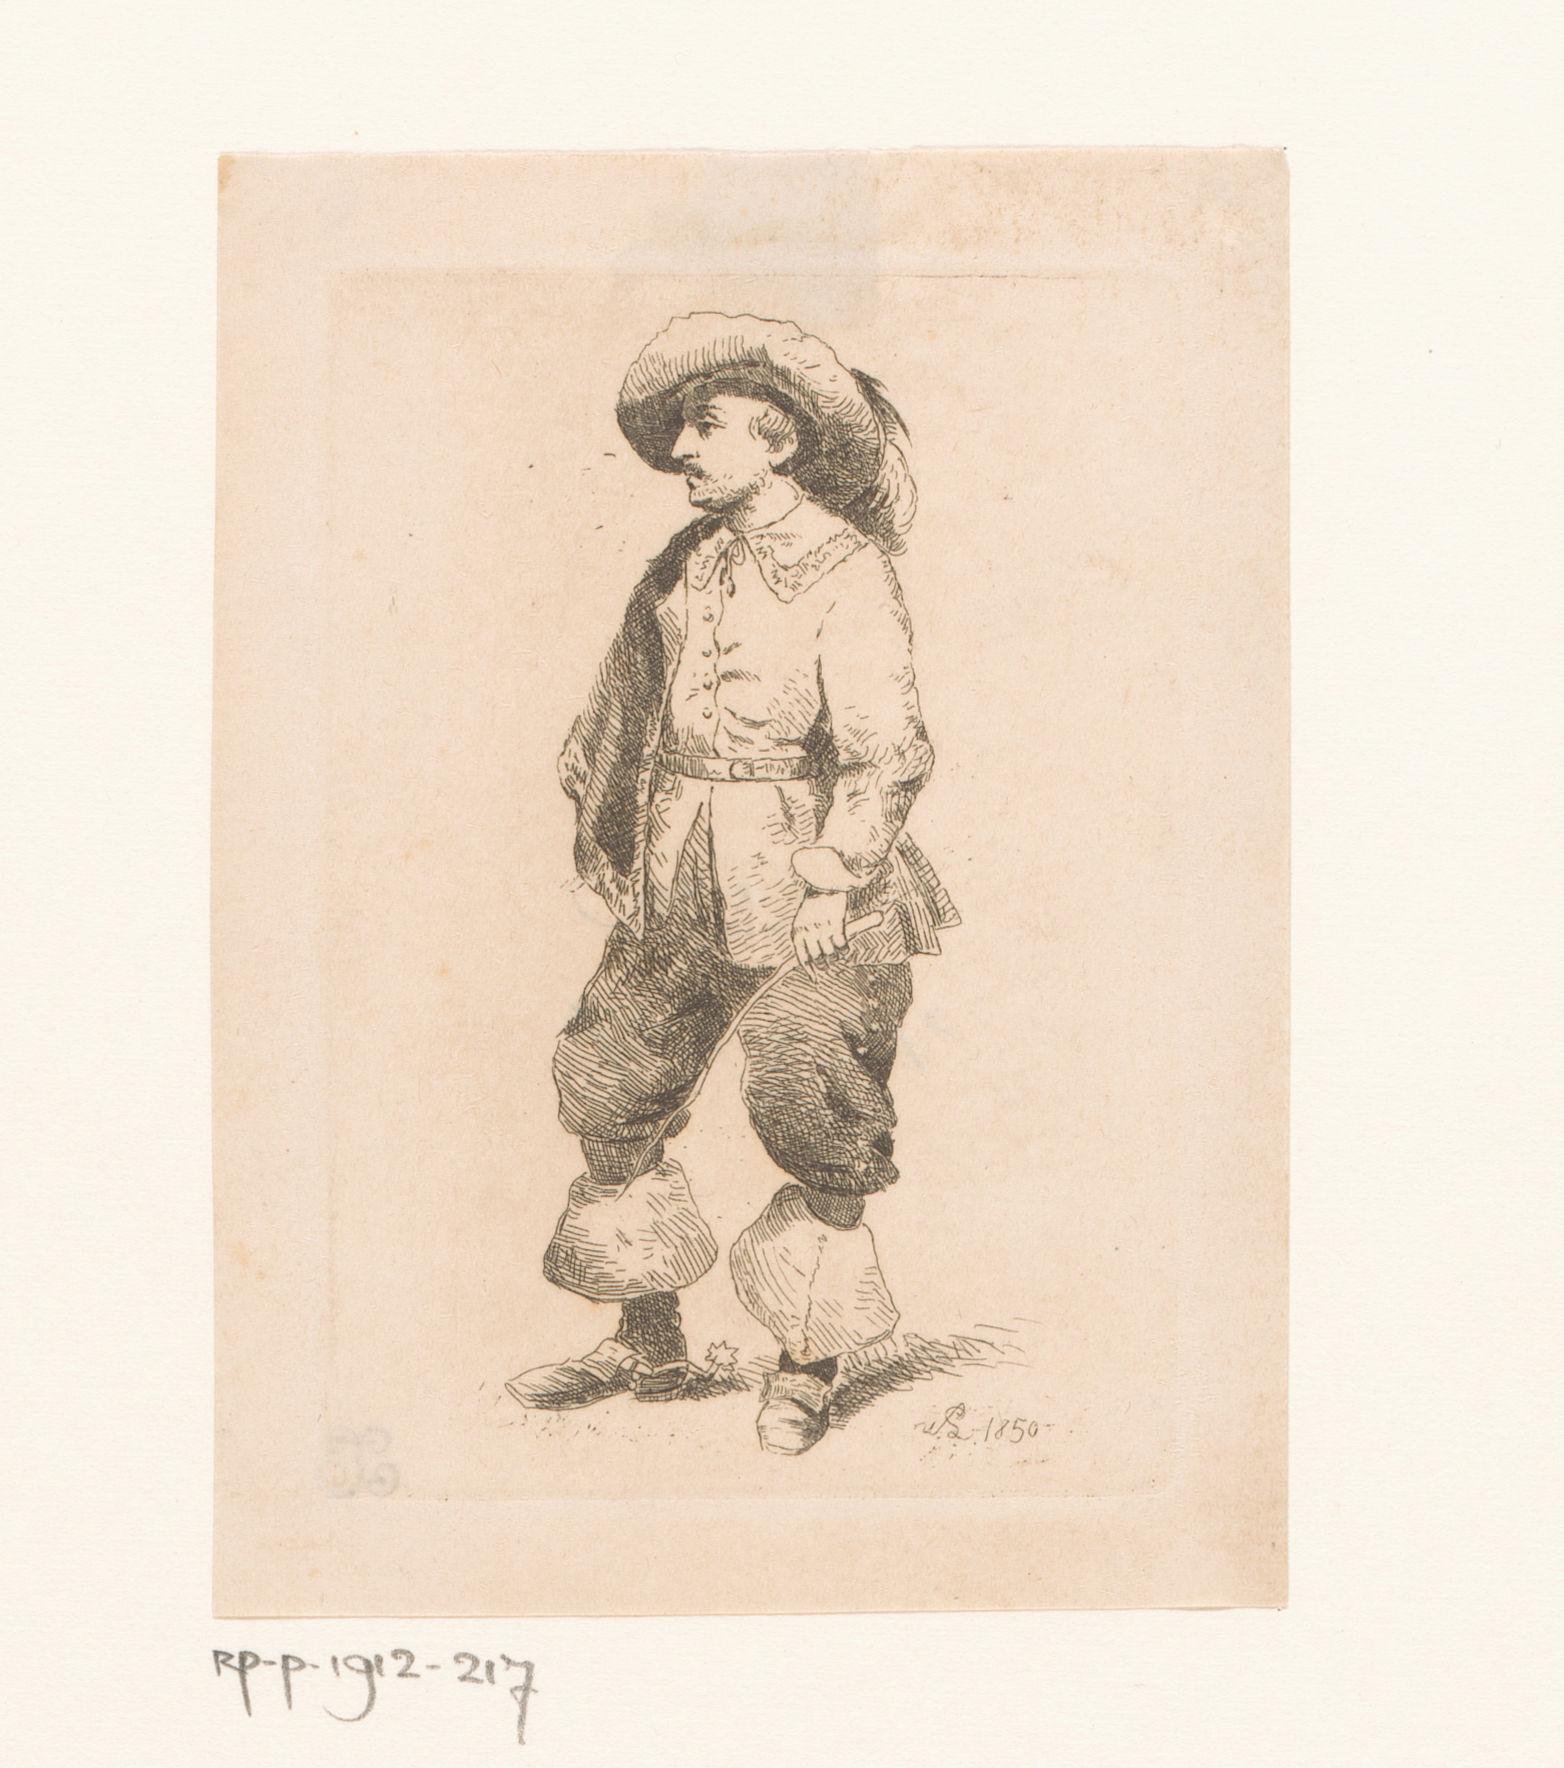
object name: print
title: Man met mantel, sporen aan zijn laarzen en een rijzweep in de hand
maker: willem linnig (i)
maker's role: print maker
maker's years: 1819-1885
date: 1850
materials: paper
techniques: etching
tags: riding a horse, ass, or mule; rider, horseman, spur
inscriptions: collector's mark: Lugt 2228, collector's mark: Lugt 1485